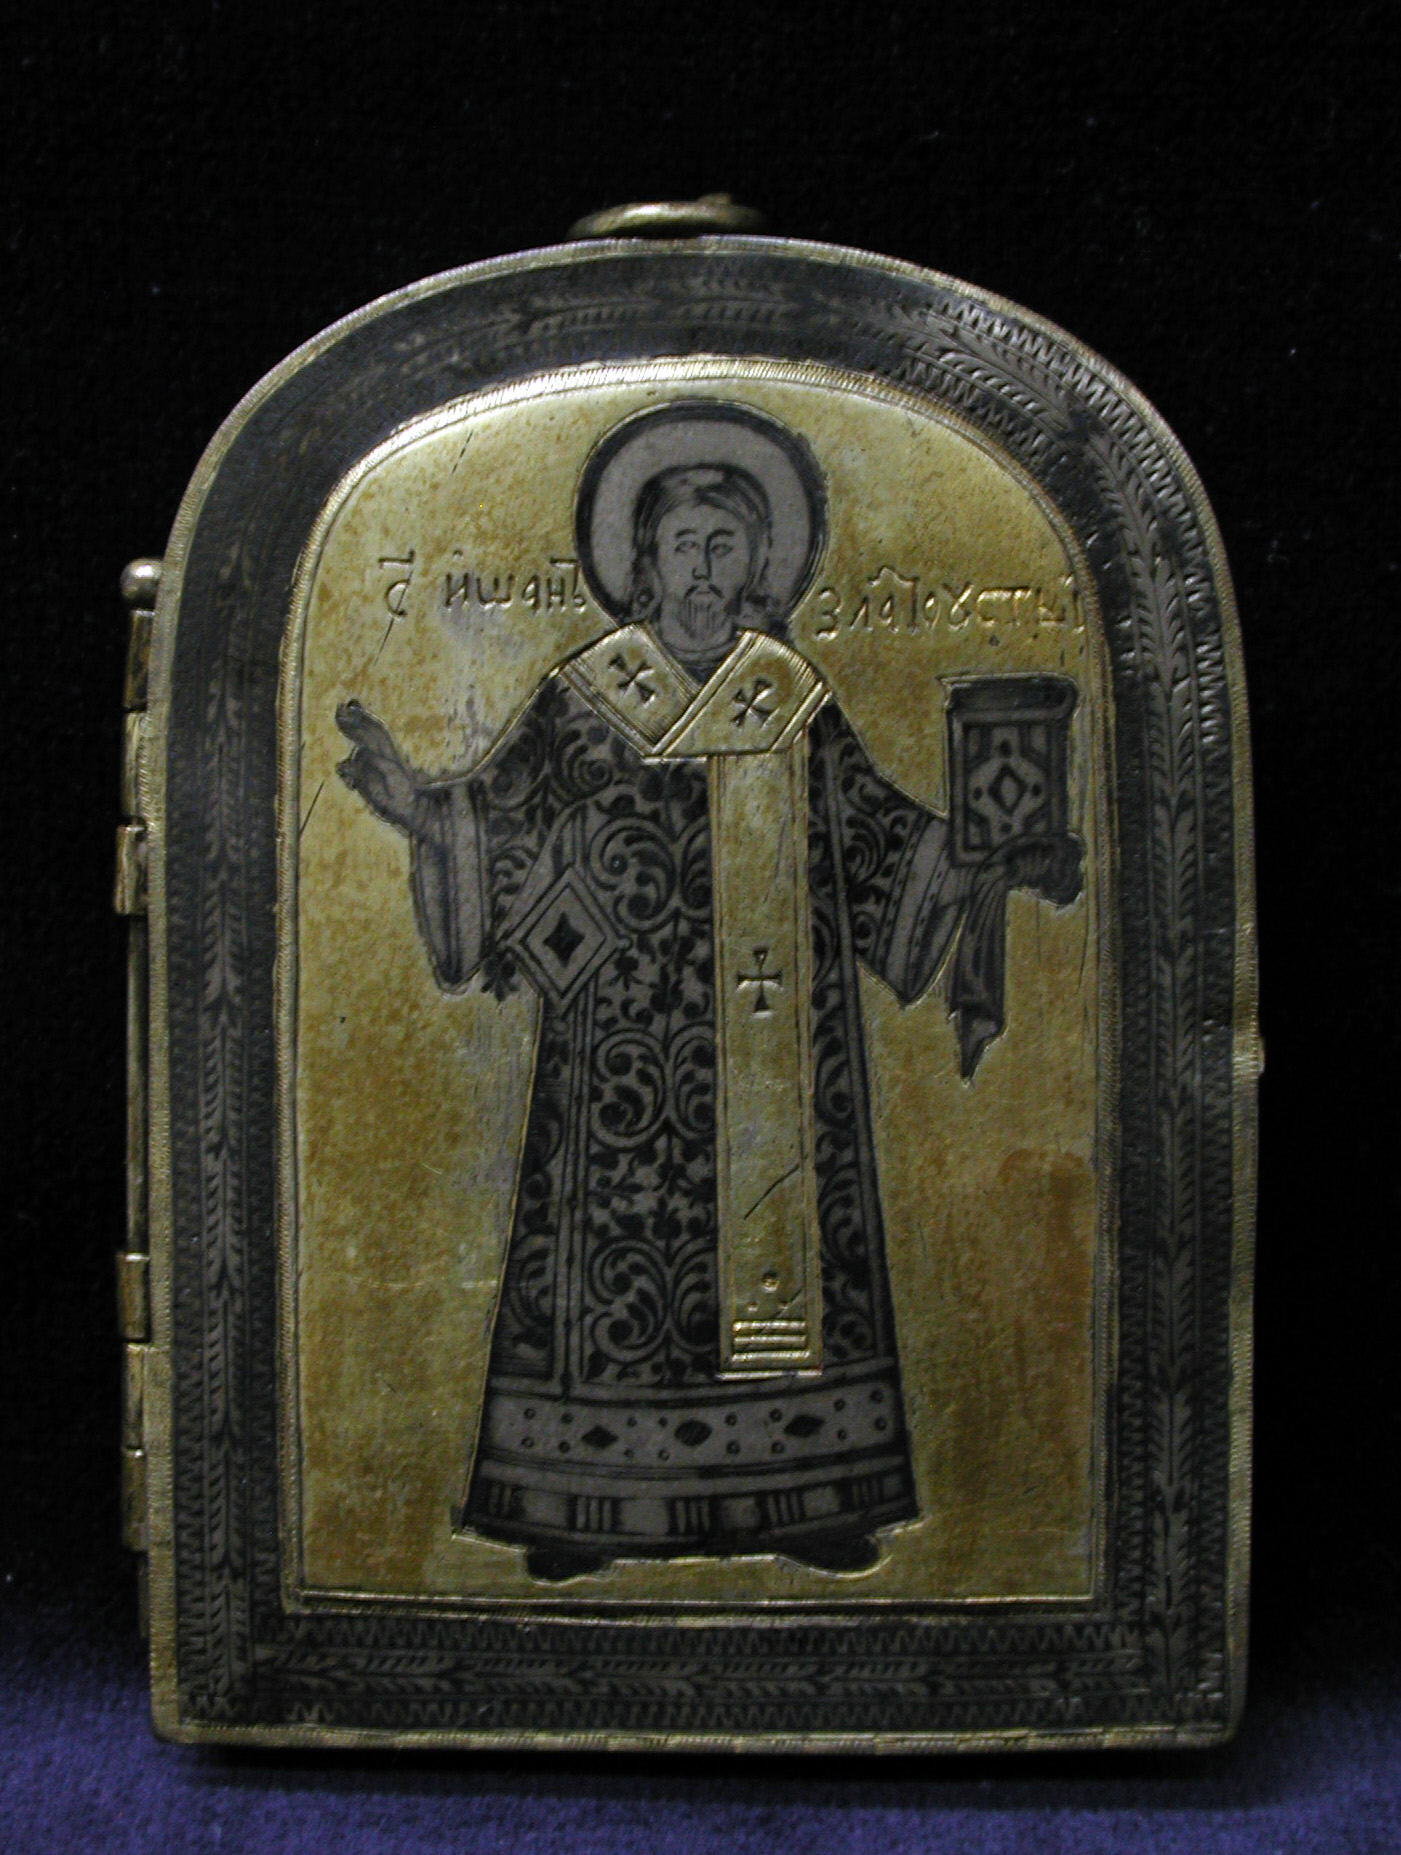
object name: sacrament box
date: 1701-1733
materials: gilt, niello, silver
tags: saints